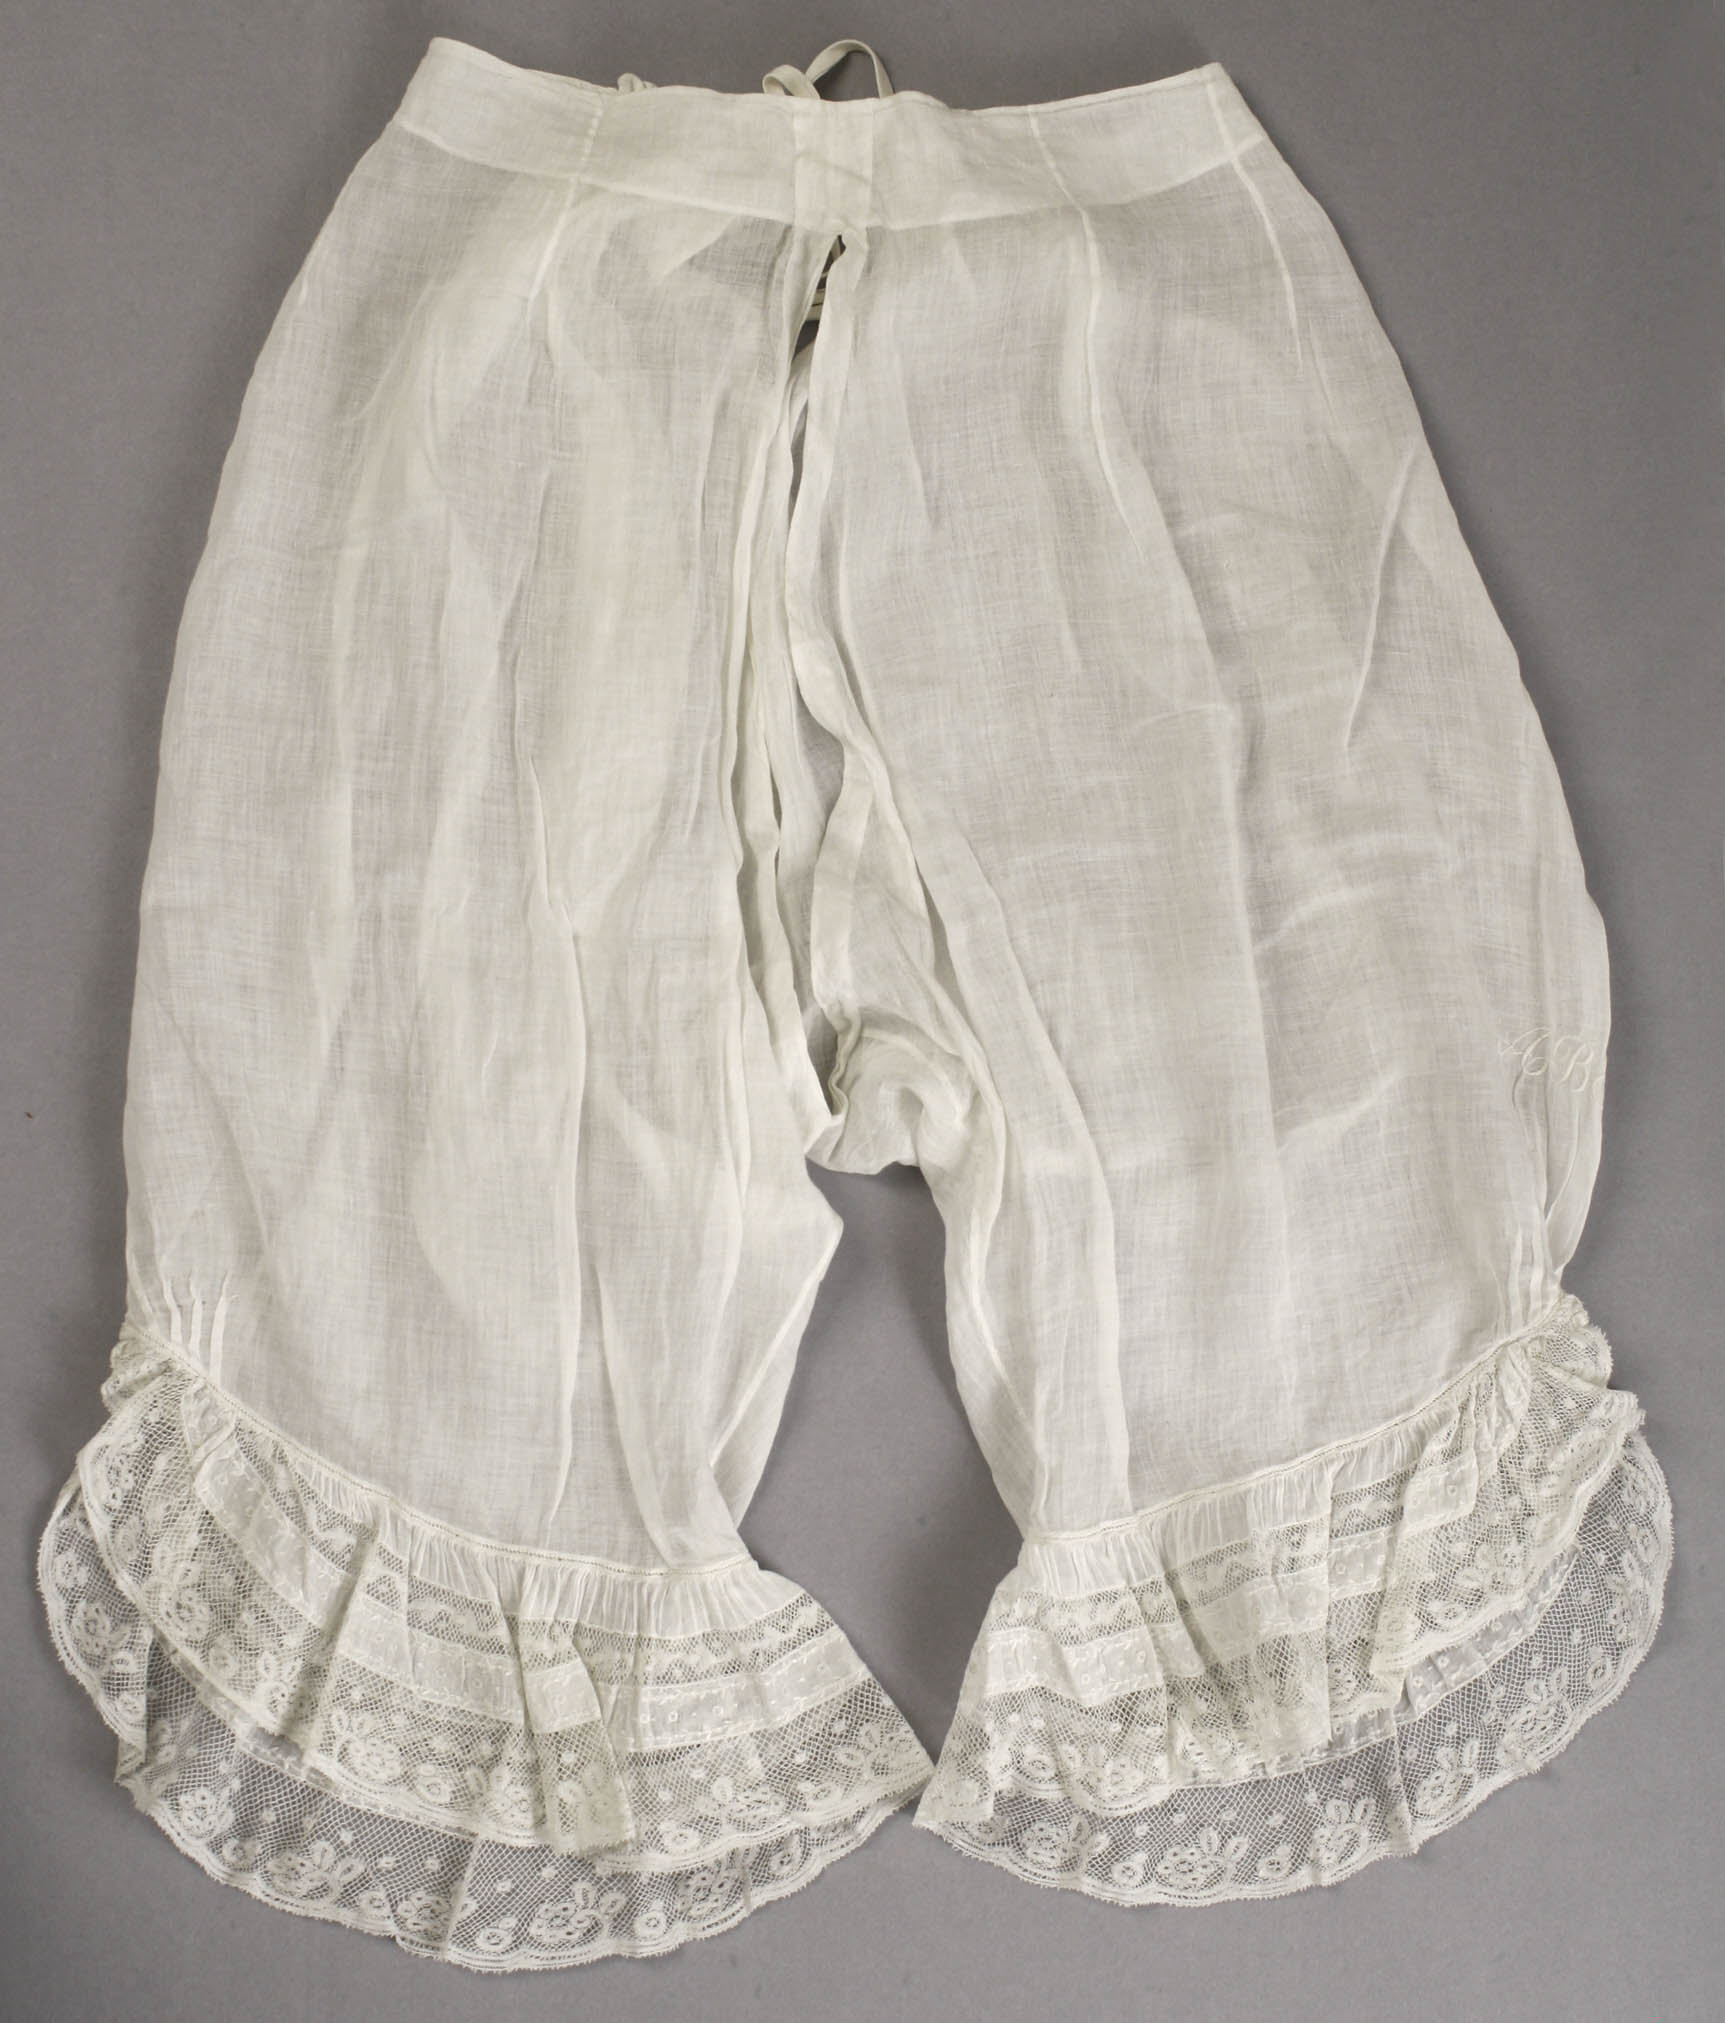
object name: drawer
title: Drawers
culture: american or european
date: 1885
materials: cotton